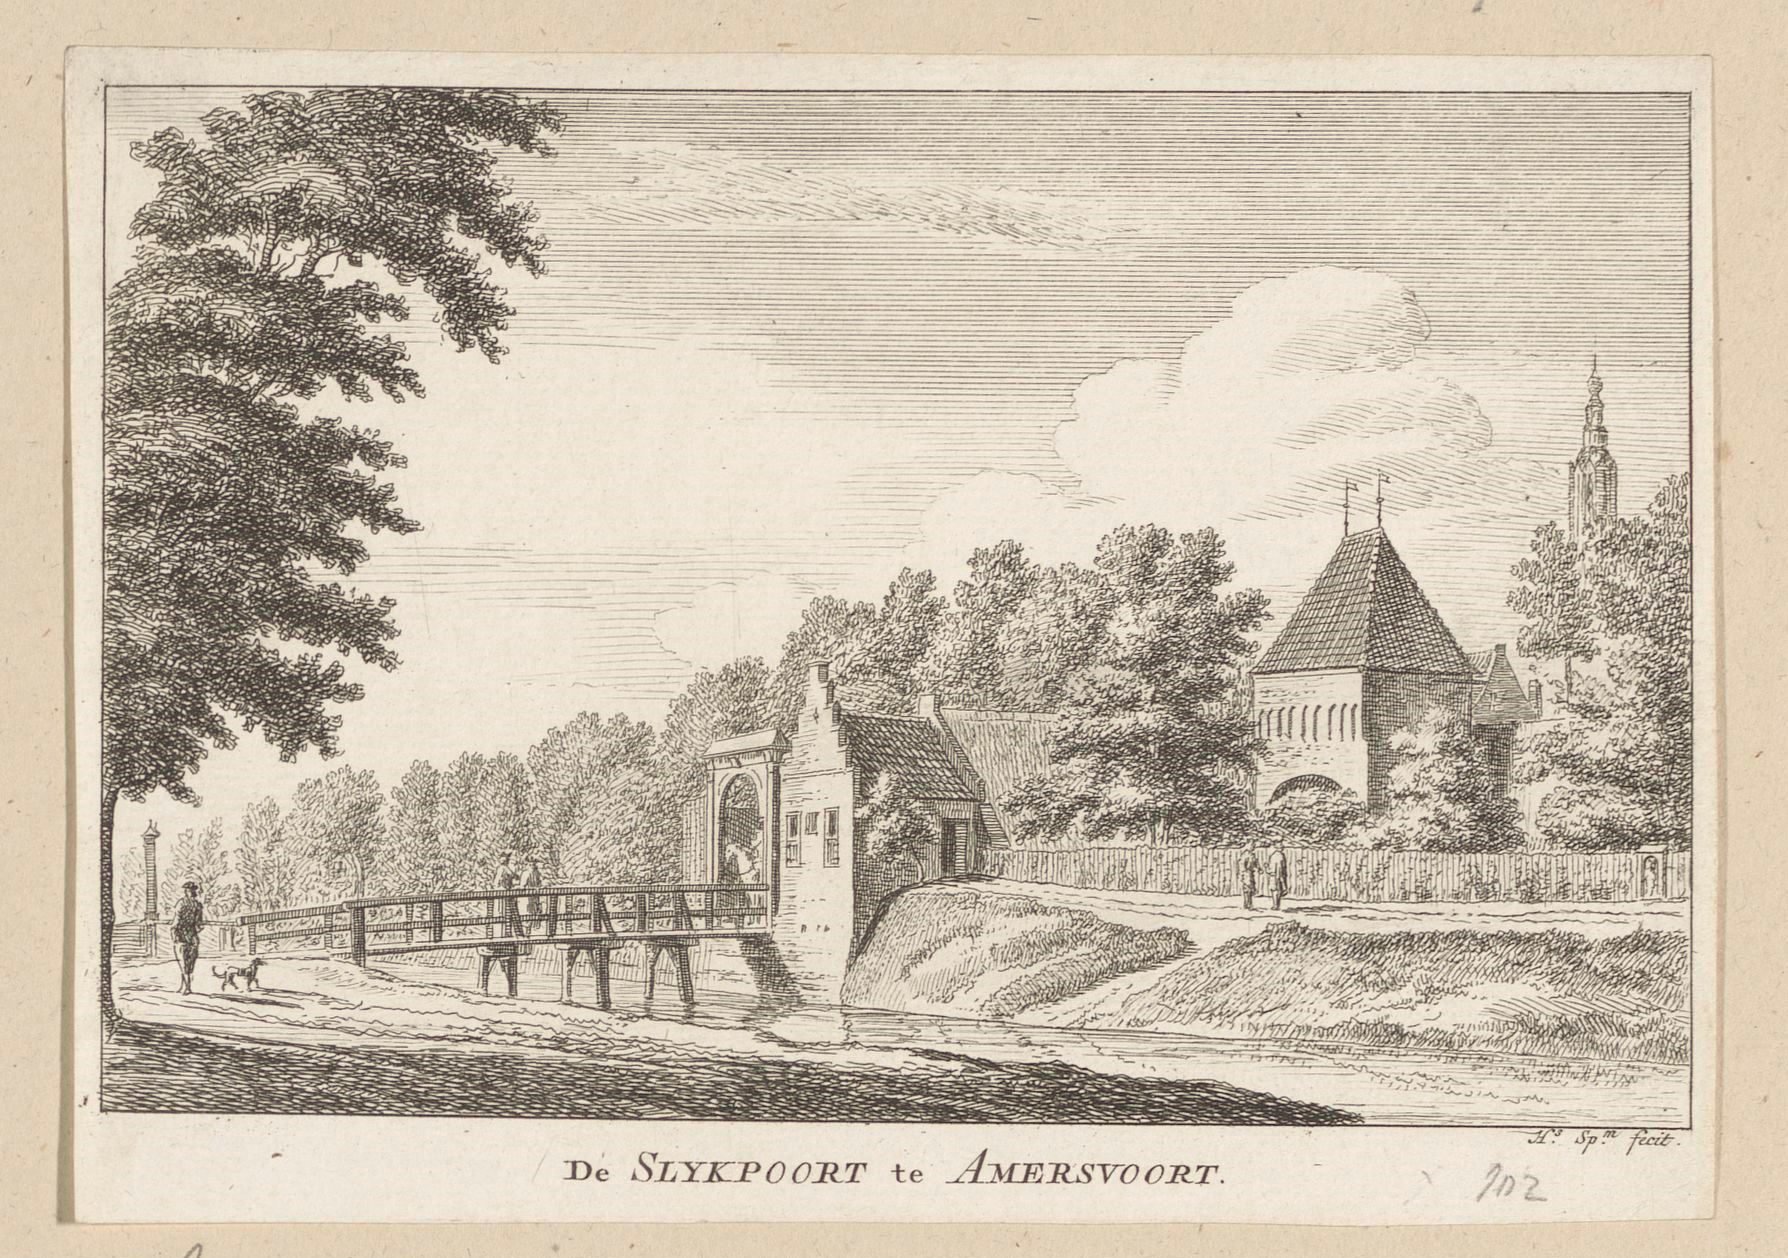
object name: print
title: Gezicht op de Slijkpoort te Amersfoort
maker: hendrik spilman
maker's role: draughtsman, painter, print maker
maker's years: 1721-1784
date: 1742-1784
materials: paper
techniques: engraving, etching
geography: haarlem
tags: bridge, city-gate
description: Gezicht op de Slijkpoort te Amersfoort met een brug over de singel en helemaal rechts de Onze-Lieve-Vrouwetoren.